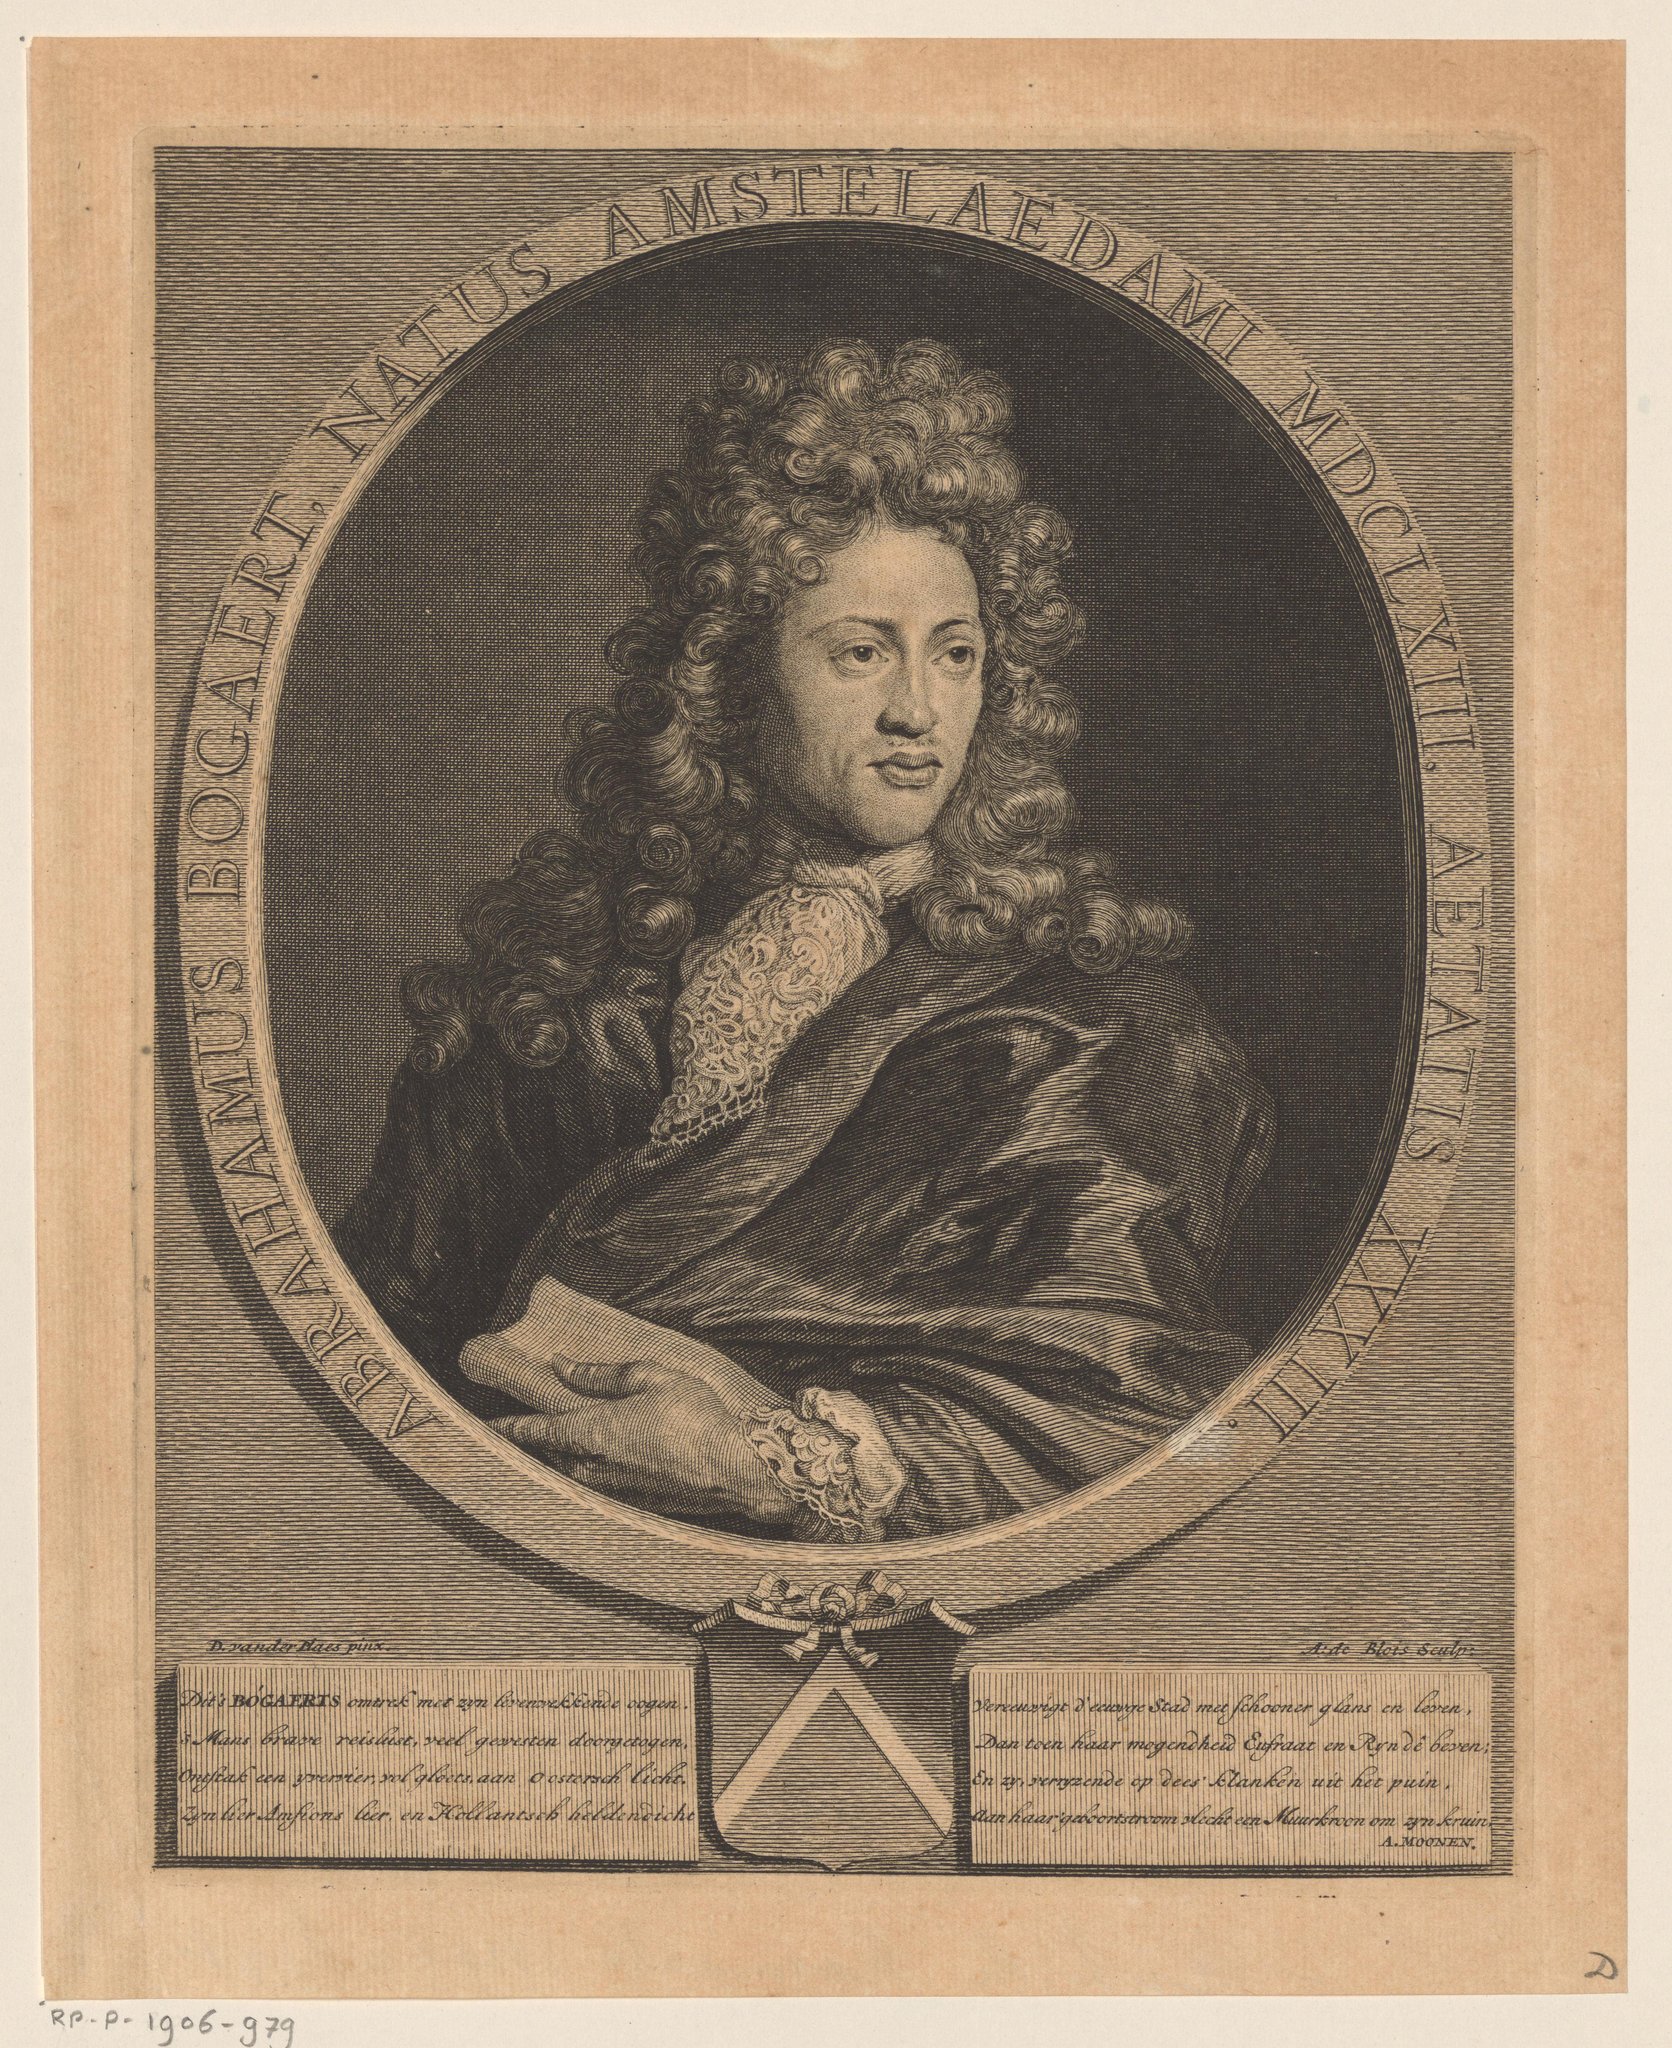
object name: print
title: Portret van Abraham Bogaert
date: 1686-1717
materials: paper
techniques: engraving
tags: amsterdam, abraham bogaert, historical persons, portrait of a writer, armorial bearing, heraldry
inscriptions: collector's mark: Lugt 2228